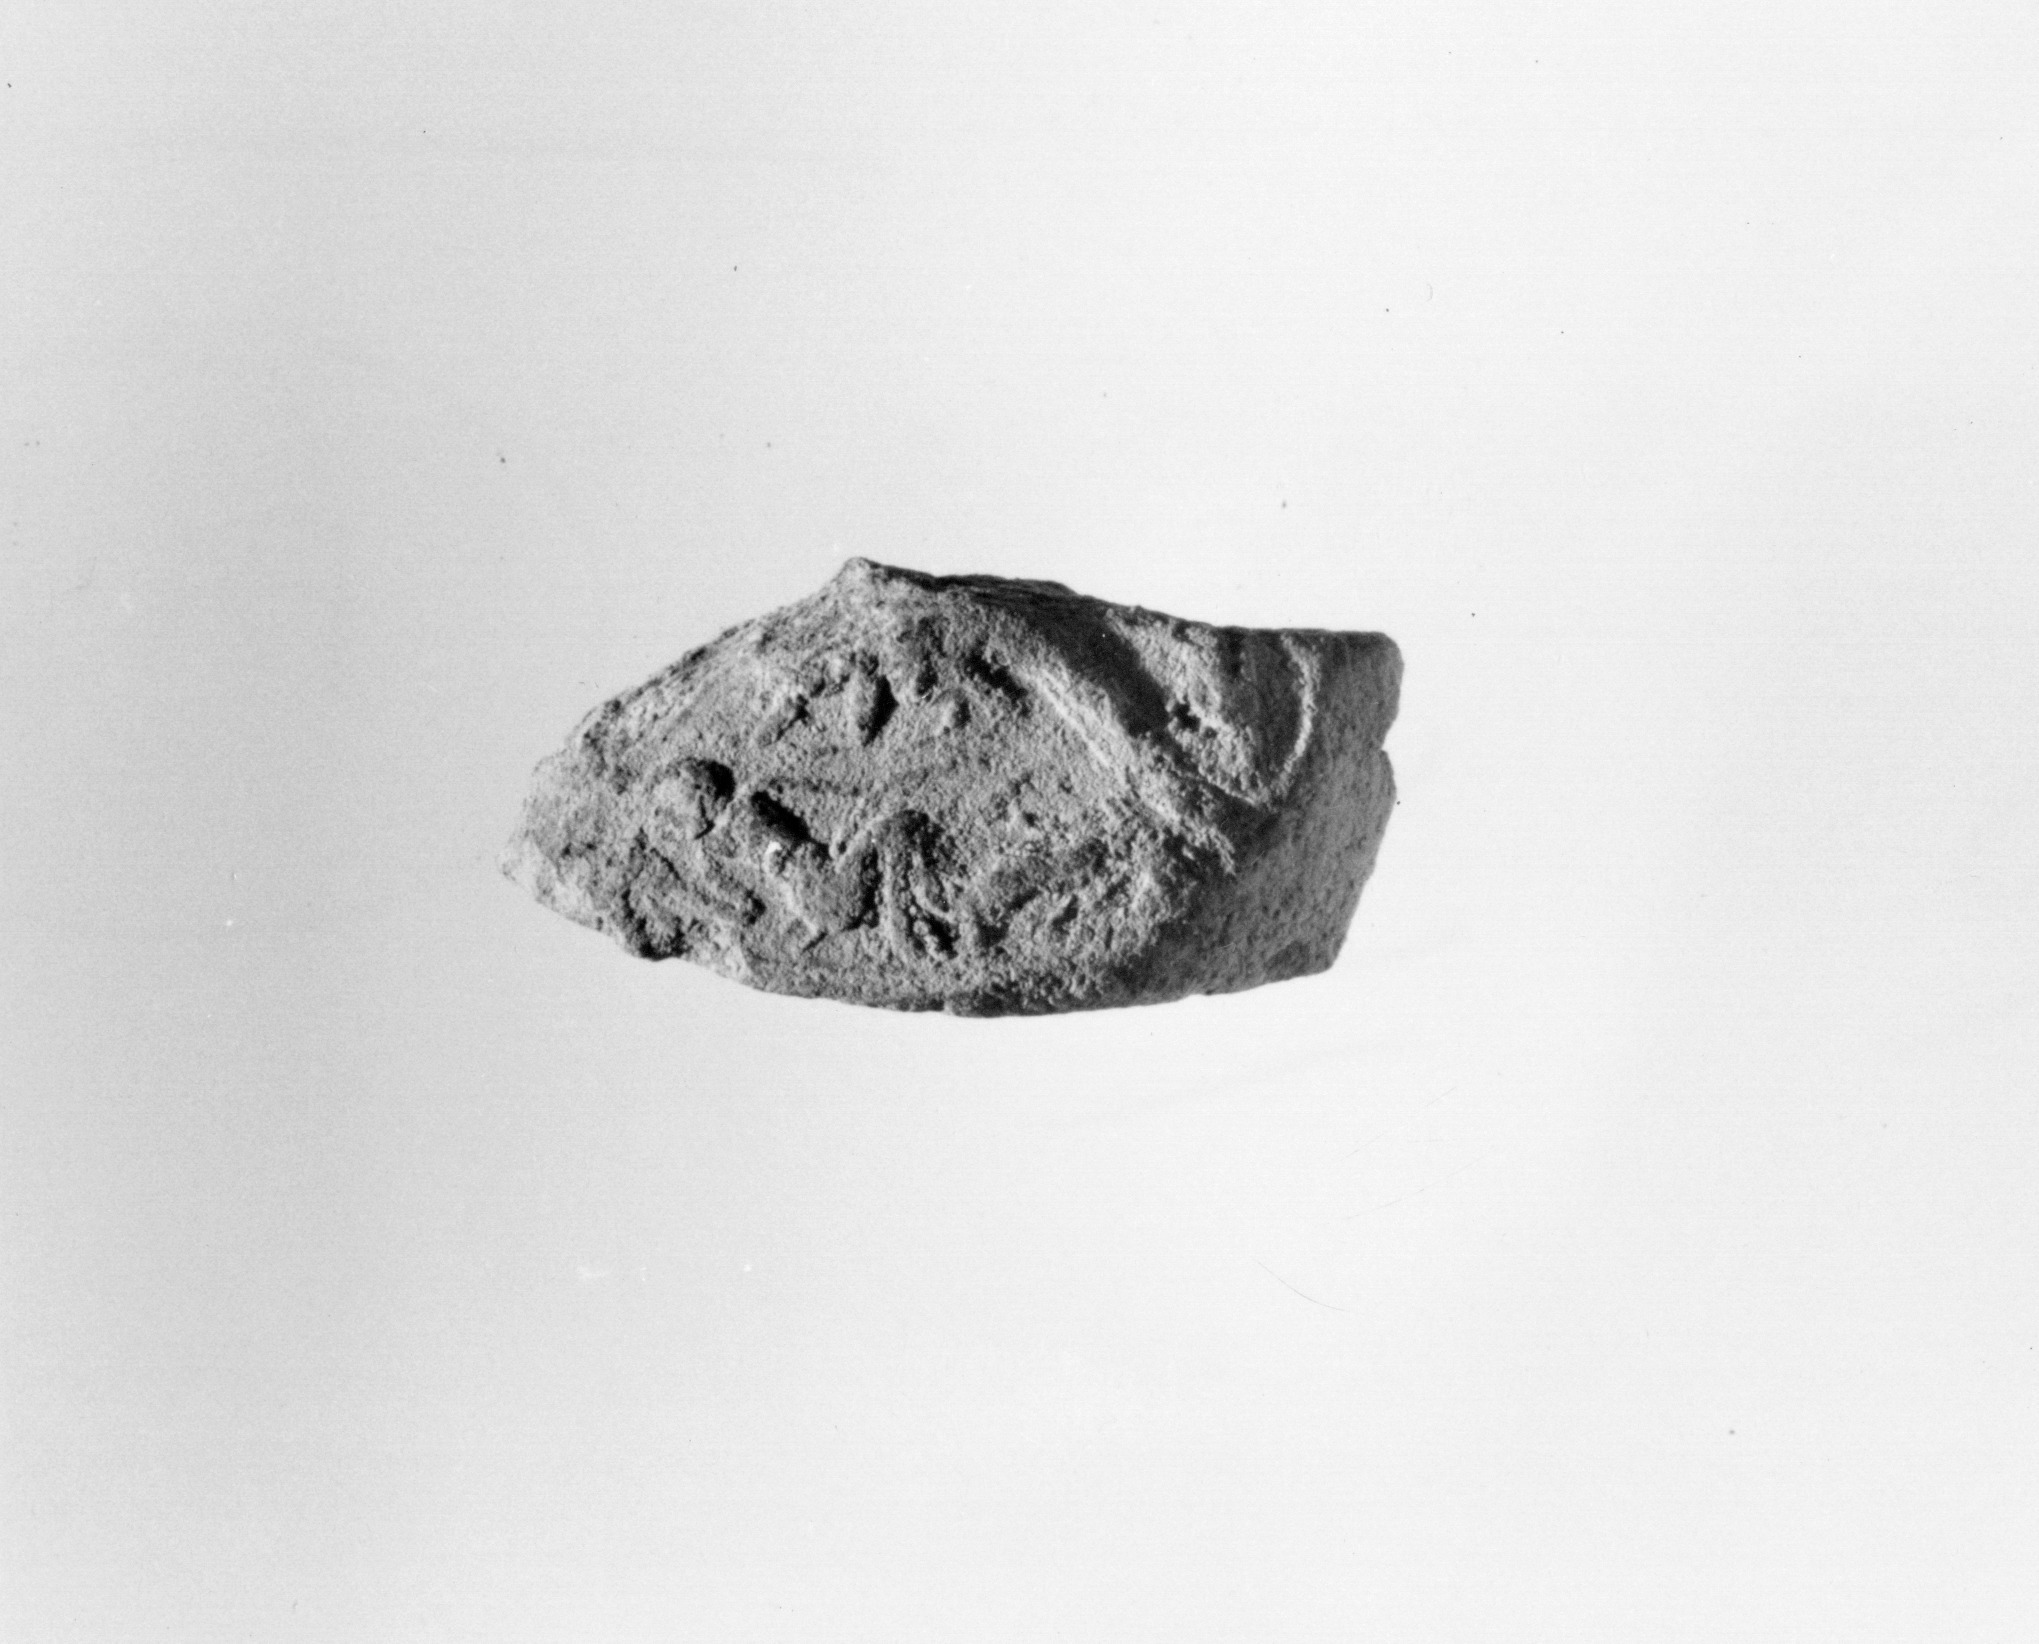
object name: sealing, nebmaatre, amenhotep iii, heb sed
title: Document Sealing With the Throne Name of Amenhotep III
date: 1390-1352 BCE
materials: mud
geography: egypt